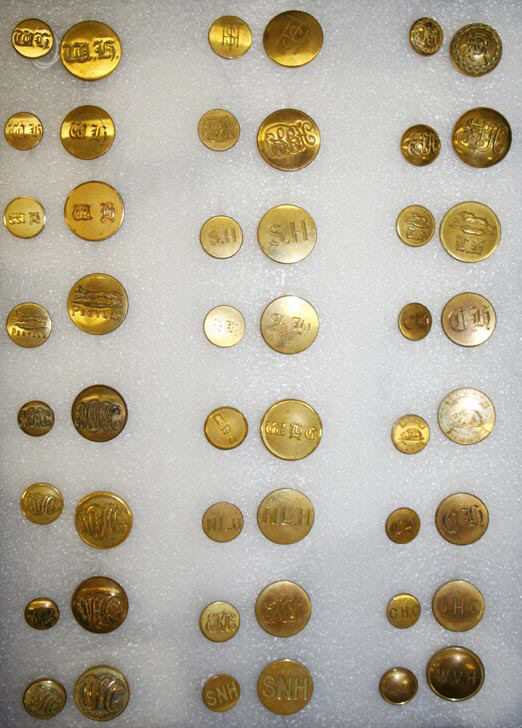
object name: button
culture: british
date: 1850-1880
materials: metal